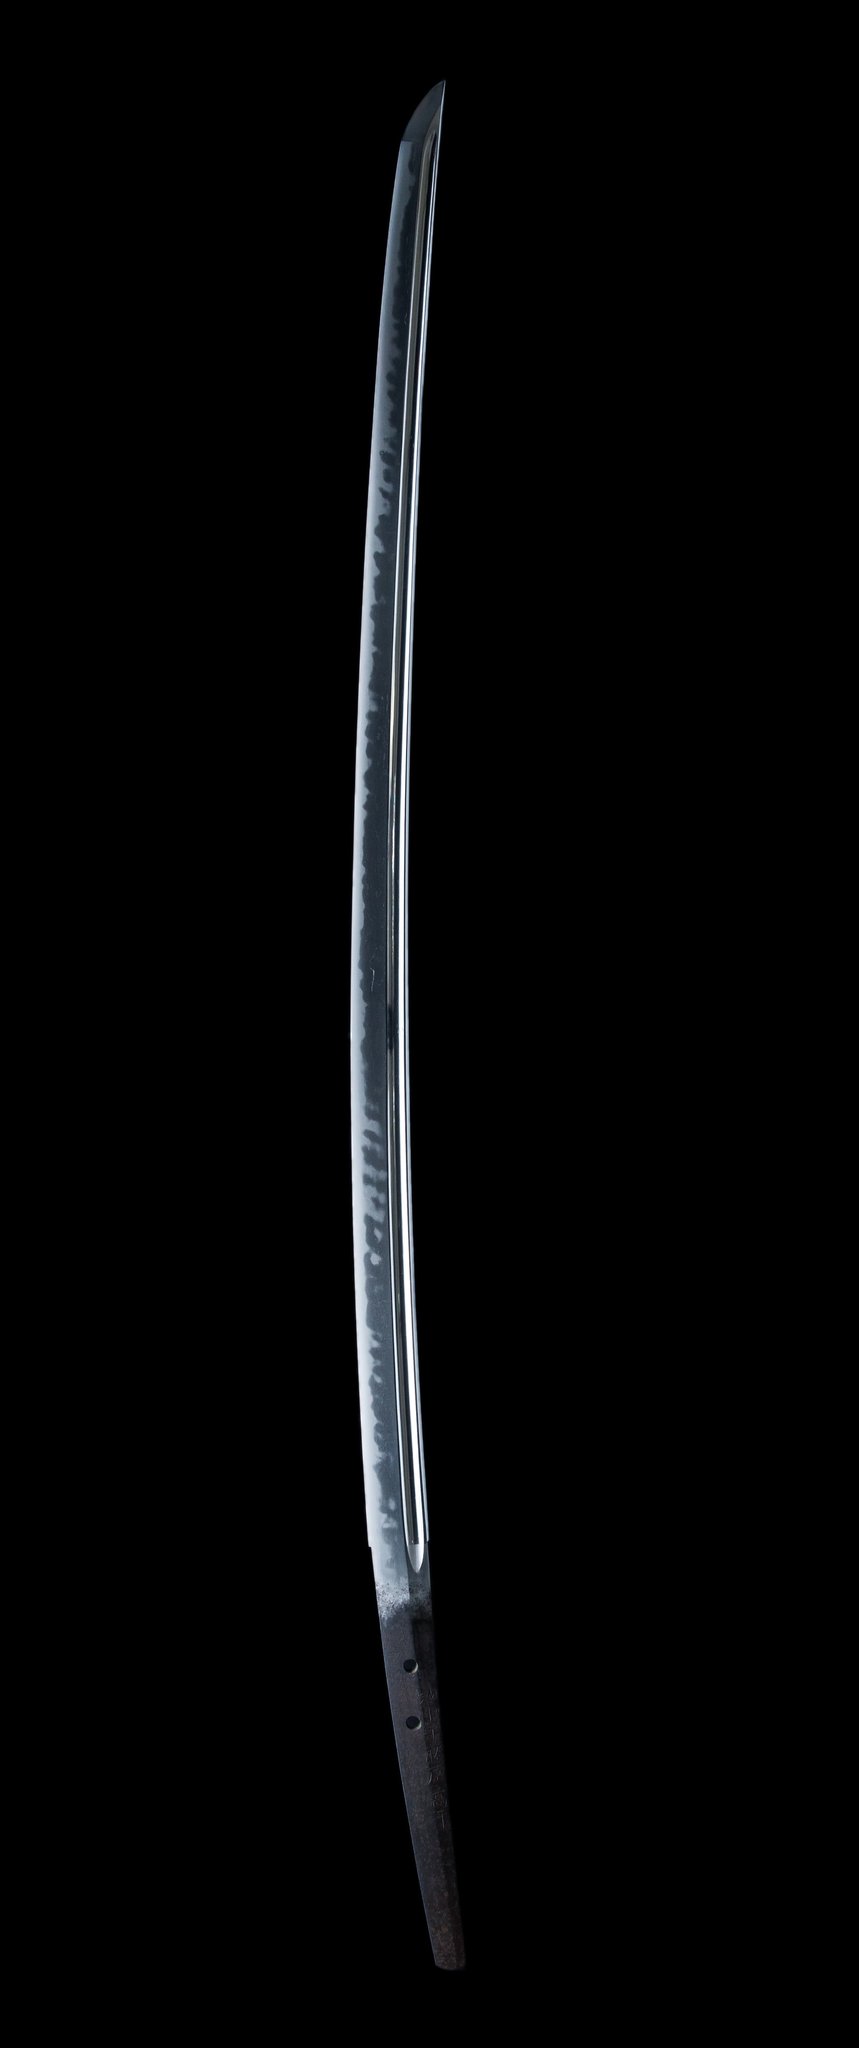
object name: blade for a sword katana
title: Blade for a Sword (Katana)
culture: japanese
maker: etchū no kami fujiwara takahira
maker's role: swordsmith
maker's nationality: japanese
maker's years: 1600-1650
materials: steel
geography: japan